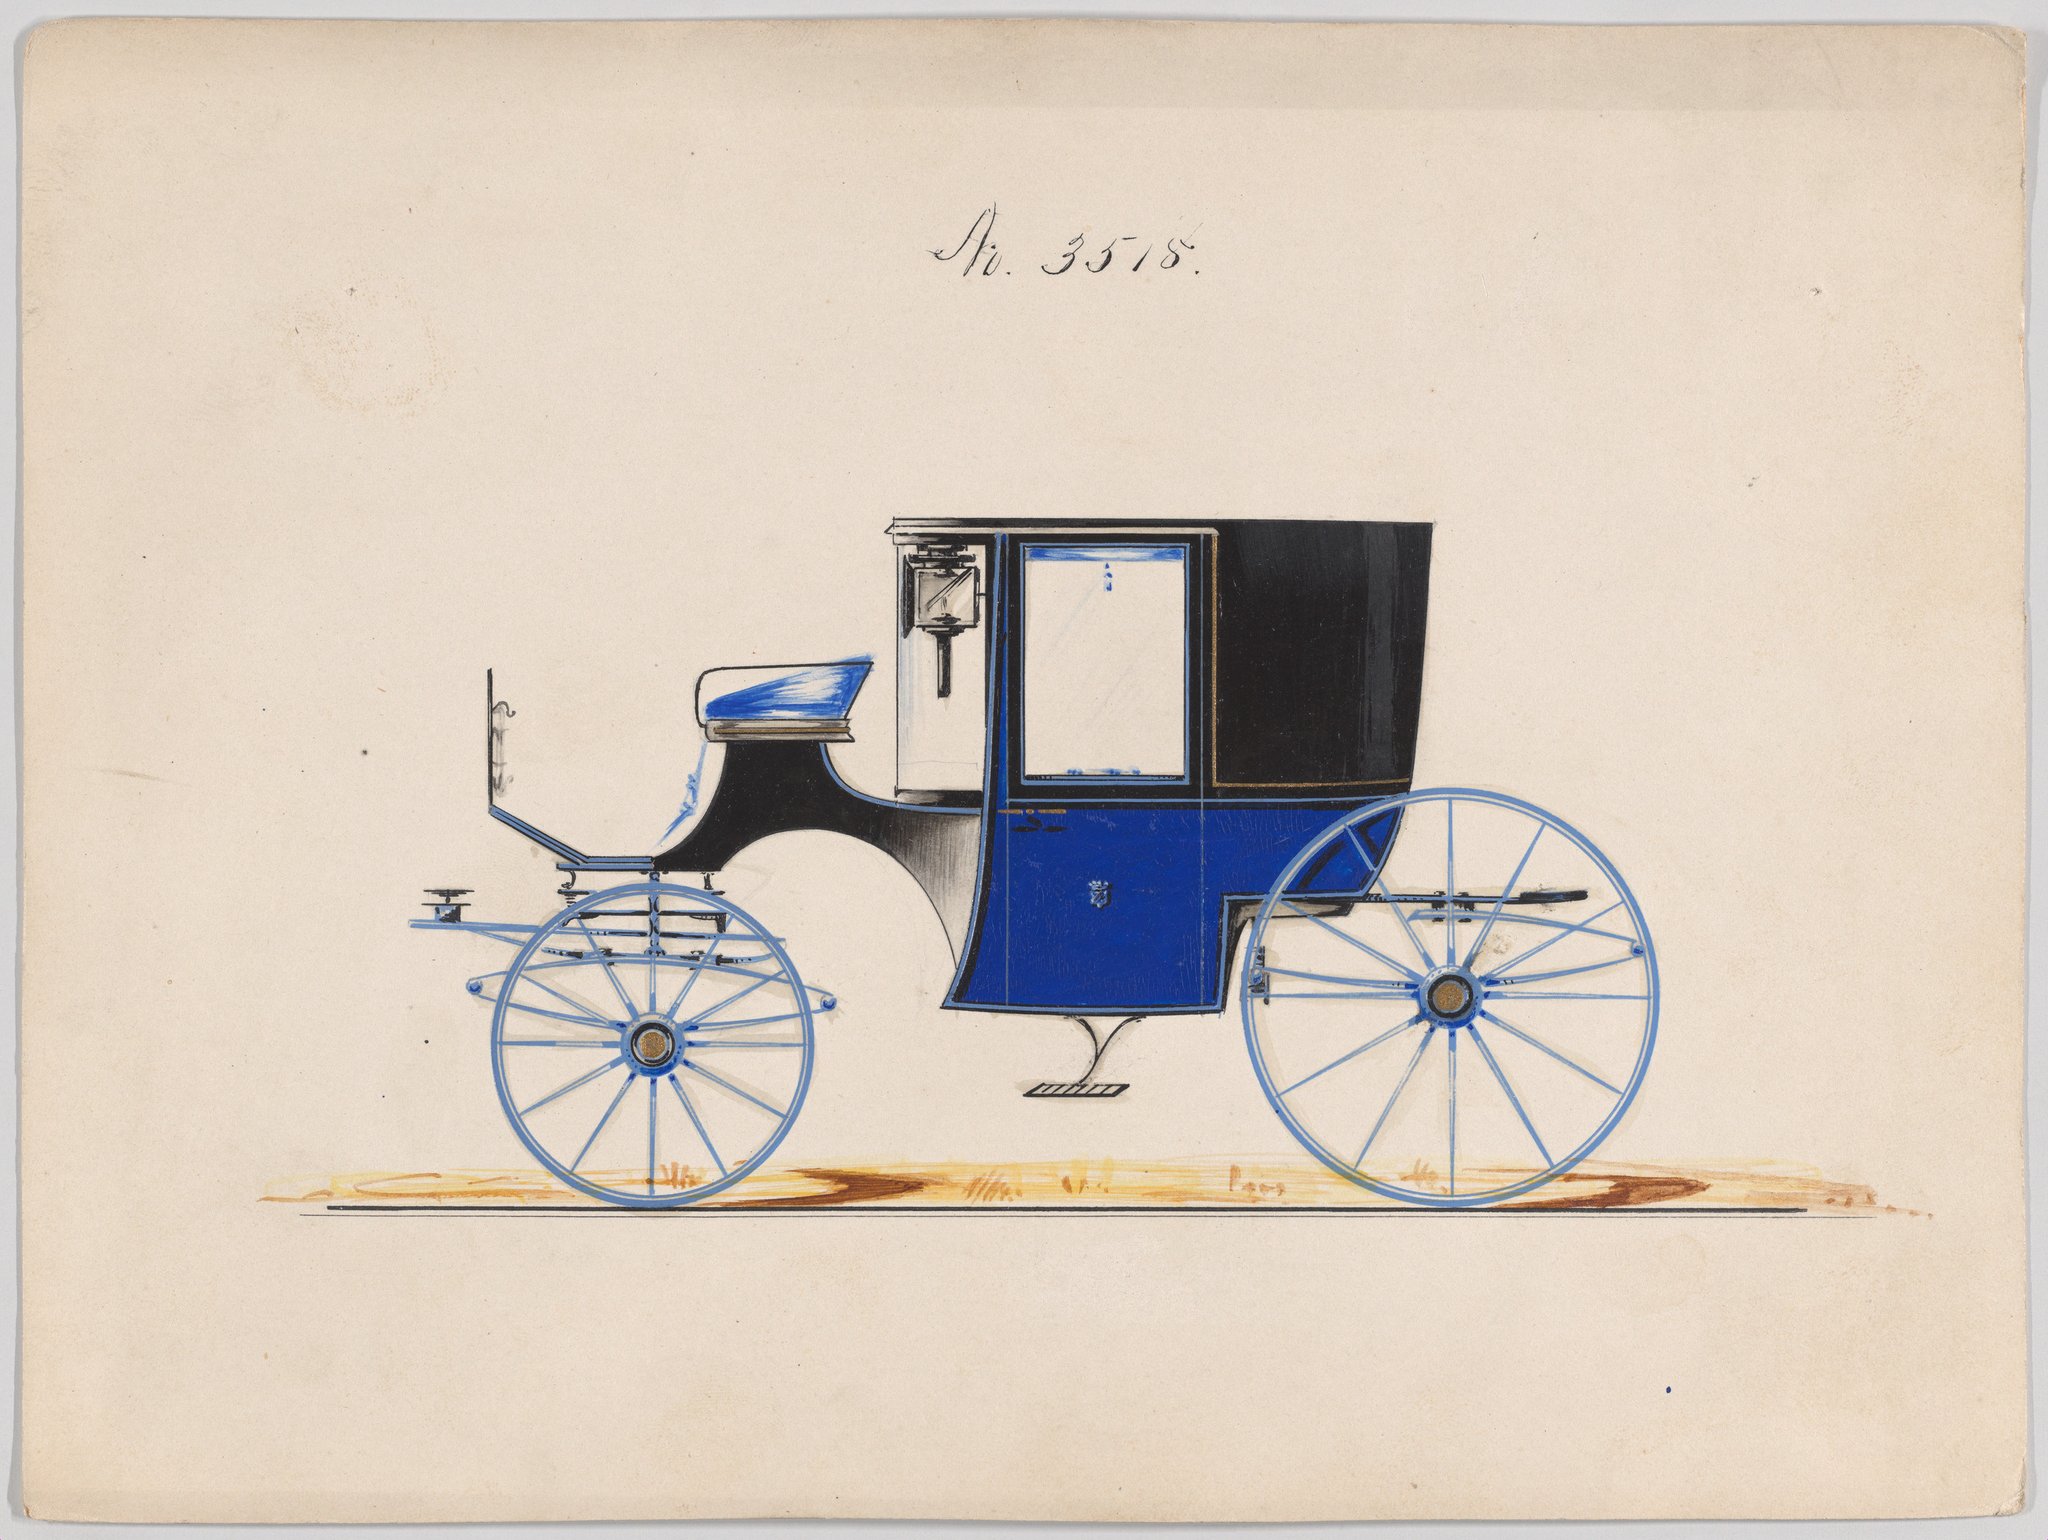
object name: drawing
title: Design for Coupé, no. 3515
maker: brewster & co.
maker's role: manufacturer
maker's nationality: american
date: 1879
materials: gouache, gum arabic, ink, watercolor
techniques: pen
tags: carriages